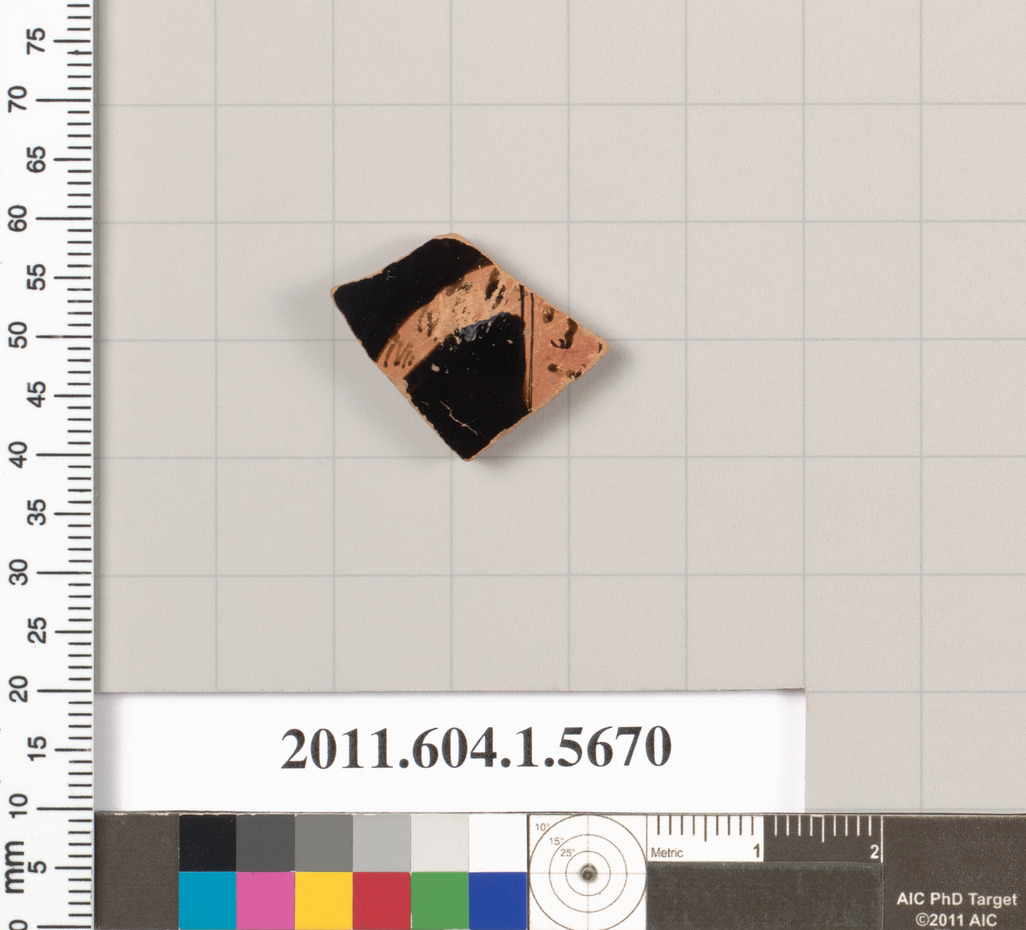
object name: kylix fragment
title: Terracotta rim fragment of a kylix (drinking cup)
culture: greek, attic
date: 490-470 BCE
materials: terracotta